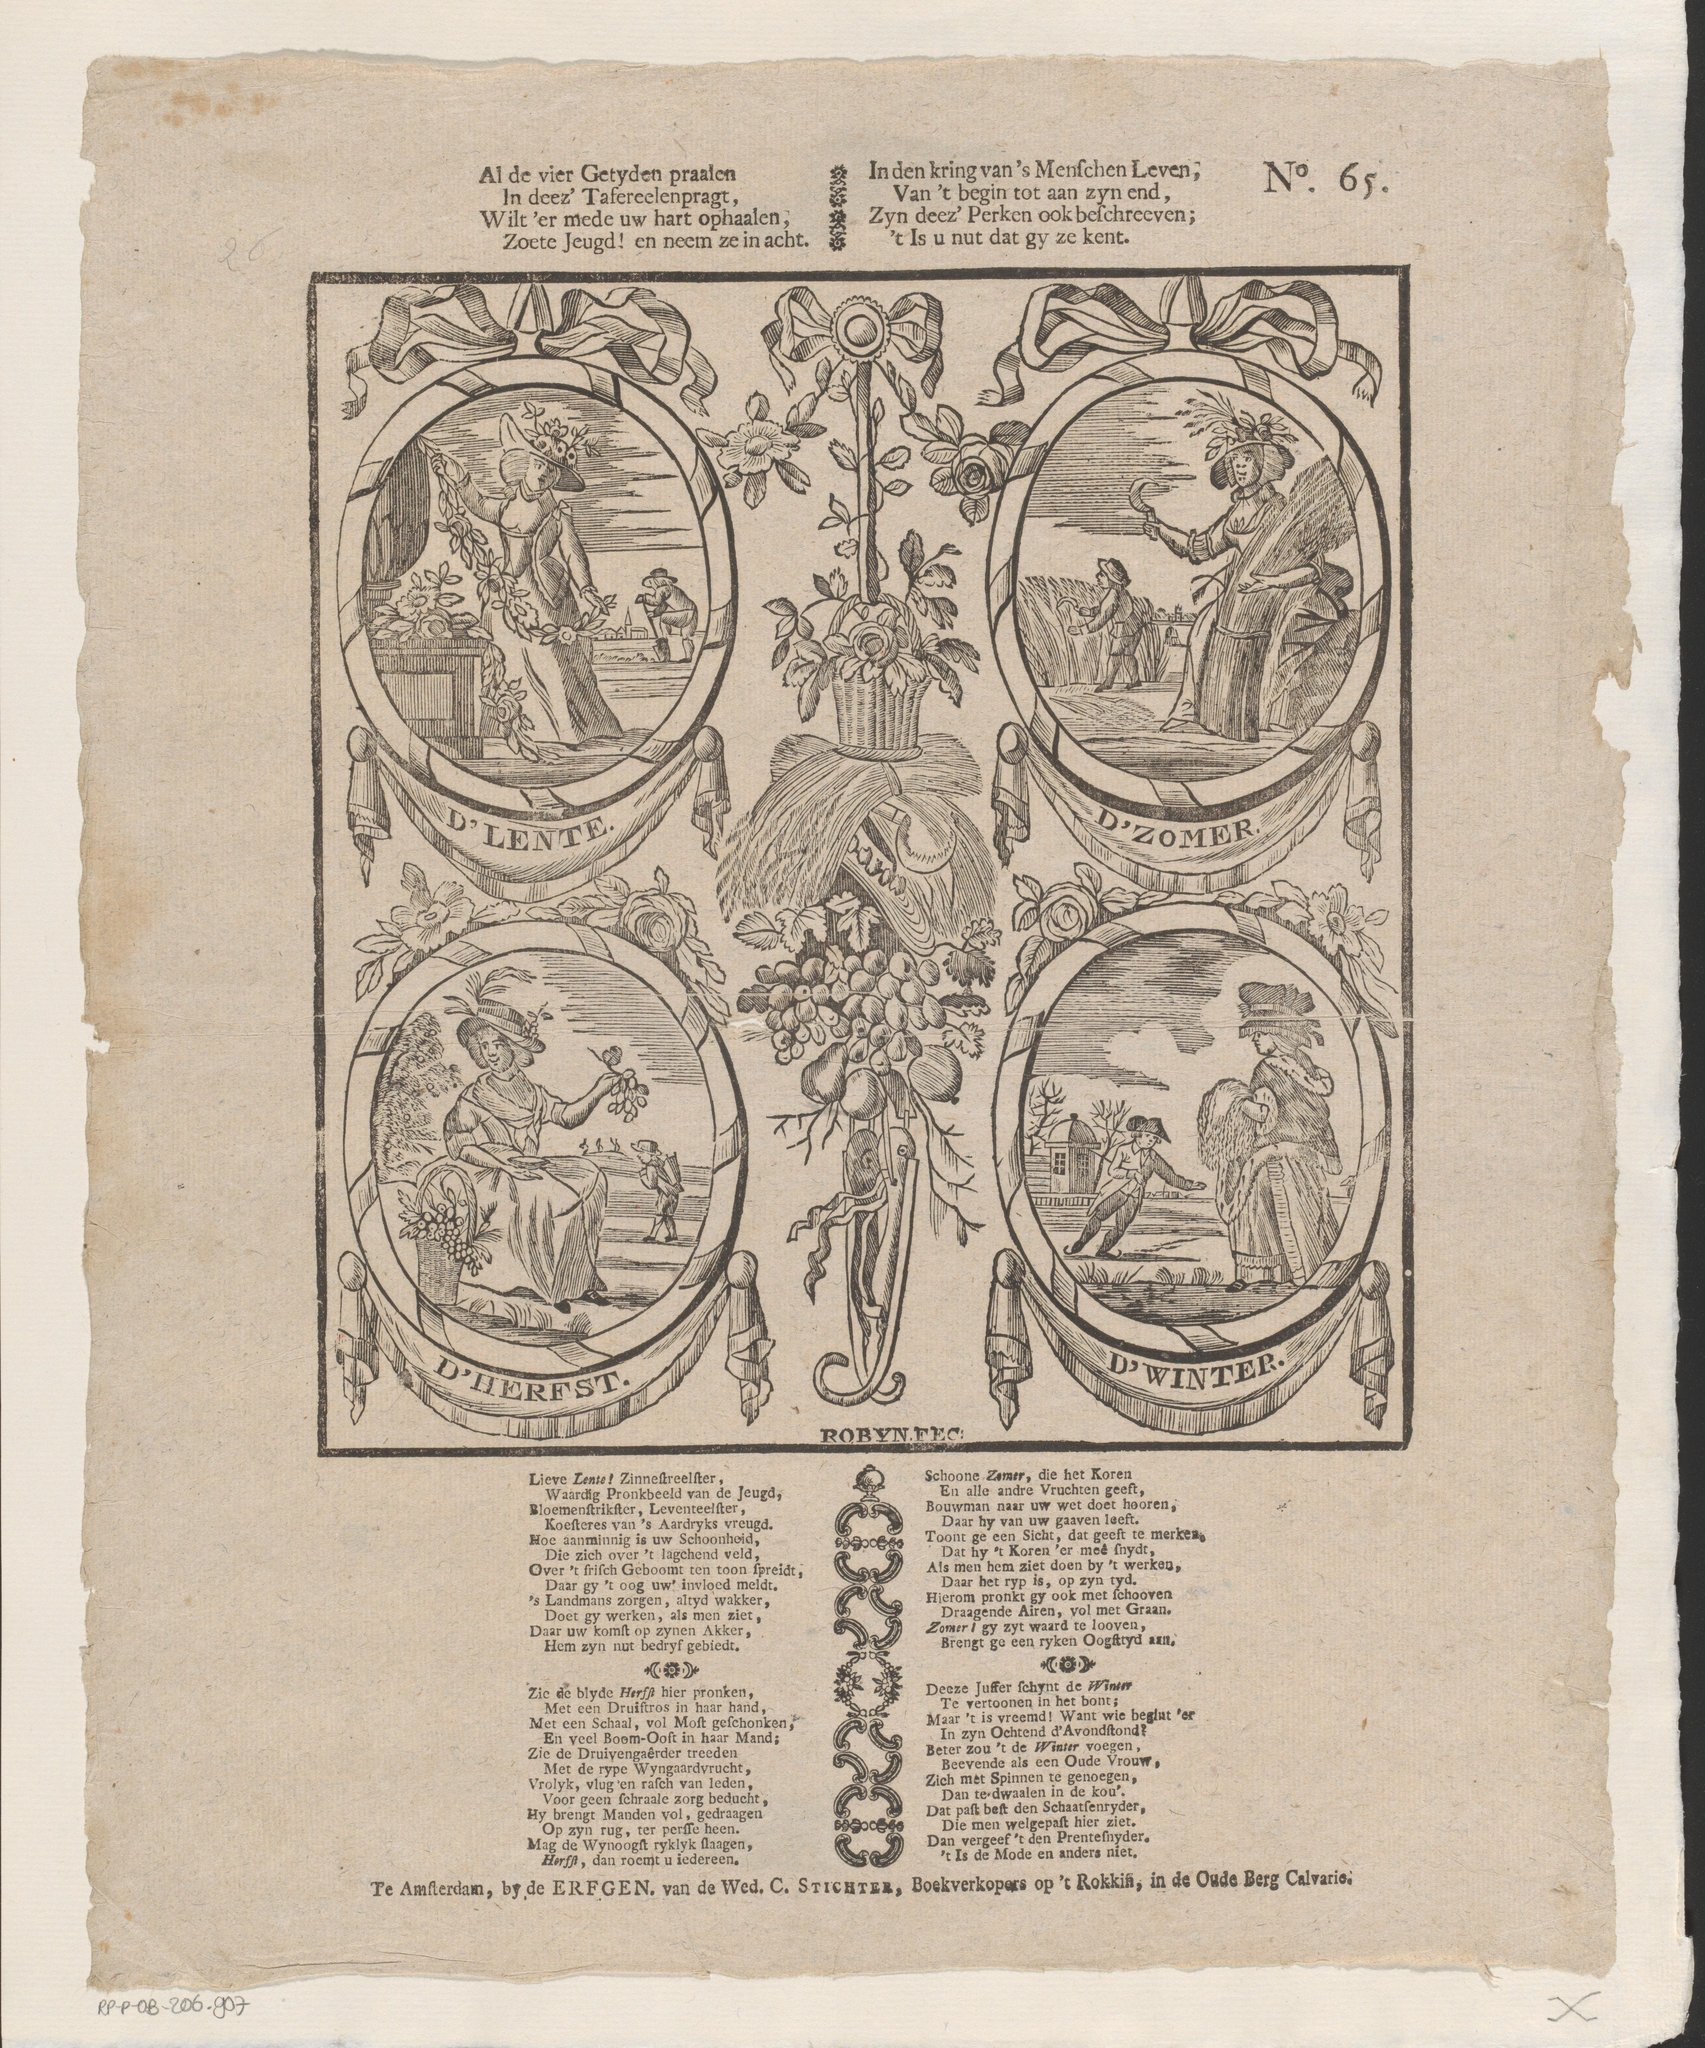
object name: print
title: Al de vier getyden praalen / In deez' tafereelenpragt [(...)]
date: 1715-1813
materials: paper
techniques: letterpress printing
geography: amsterdam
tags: the four seasons of the year ~ human activities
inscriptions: collector's mark: Lugt 2760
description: Vier medaillons met voorstellingen van de vier jaargetijden en bijbehorende activiteiten. Tussen de medaillons een trofee met producten uit de verschillende seizoenen. In de ondermarge een vers in twee kolommen. Genummerd rechtsboven: No. 65.